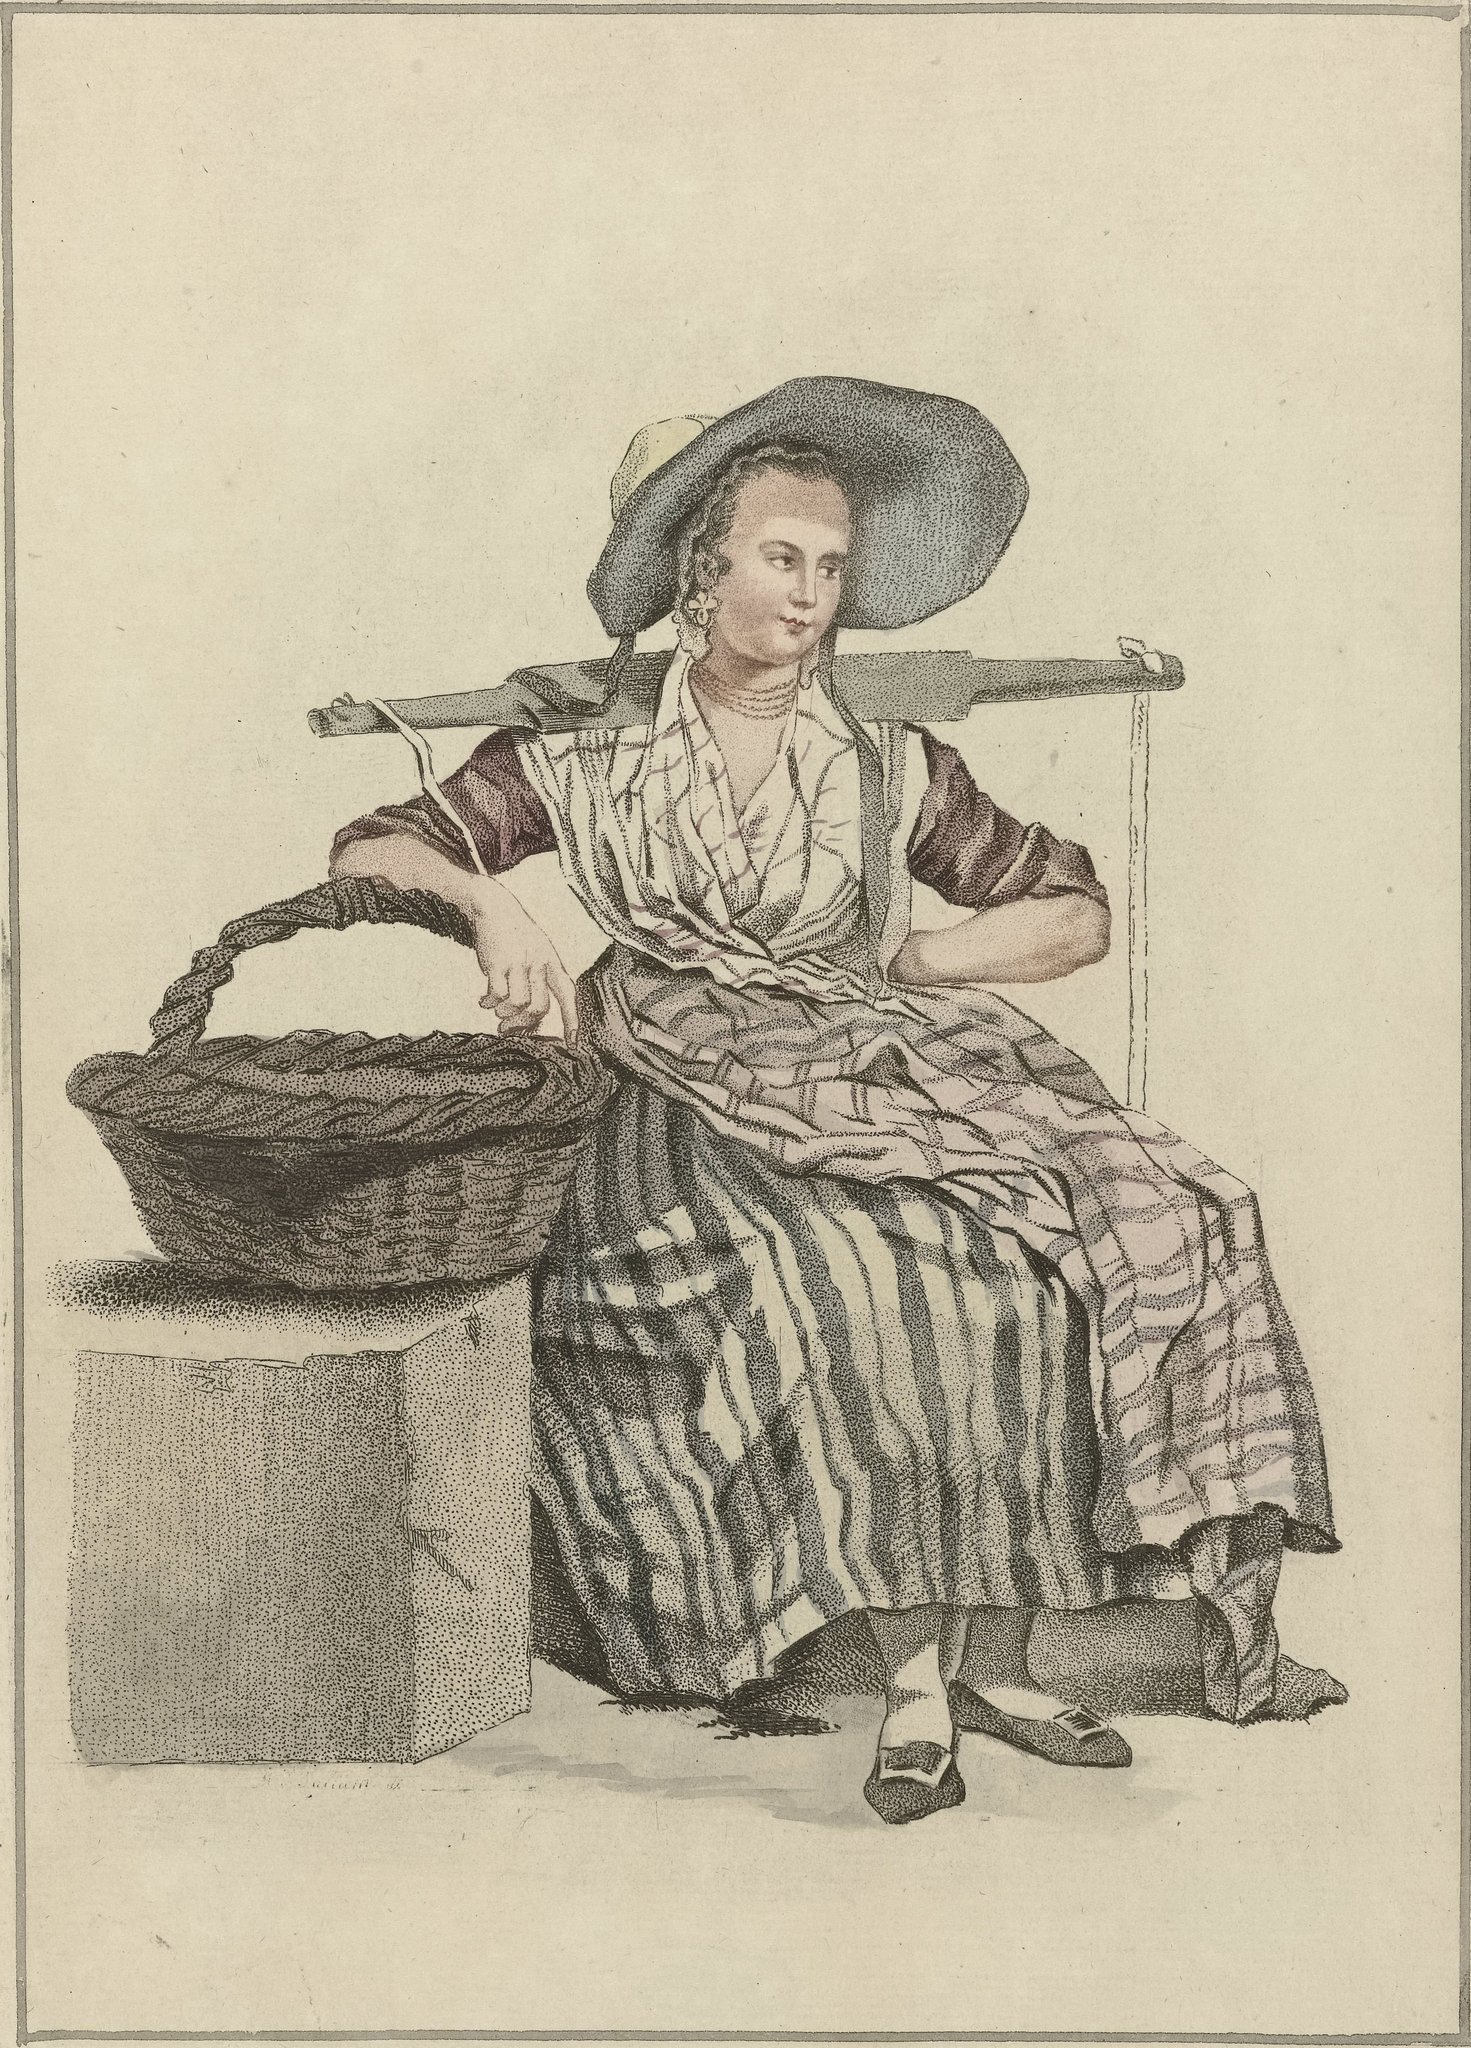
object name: print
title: Zittende boerenvrouw met mand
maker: mathias de sallieth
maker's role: print maker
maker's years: 1749-1791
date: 1772-1791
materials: paper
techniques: printmaking, etching, hand coloring, lithography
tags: farmers - aa - female farmer, farmer's wife, container made of plant material other than wood: basket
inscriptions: collector's mark: Lugt 2228, number: ‘N 9 I - 27’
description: De prent verscheen vanaf 1818 tevens als onderdeel van een 33-delige reeks prenten door Mathias de Sallieth, samengebonden in: Perkois, Jacobus, Prins, Johannes Huibert. Verzameling van verschillende gekleede mans- en vrouwenstanden, ter oefening van jonge schilders en liefhebbers. Rotterdam: Johannes Immerzeel, 1818.